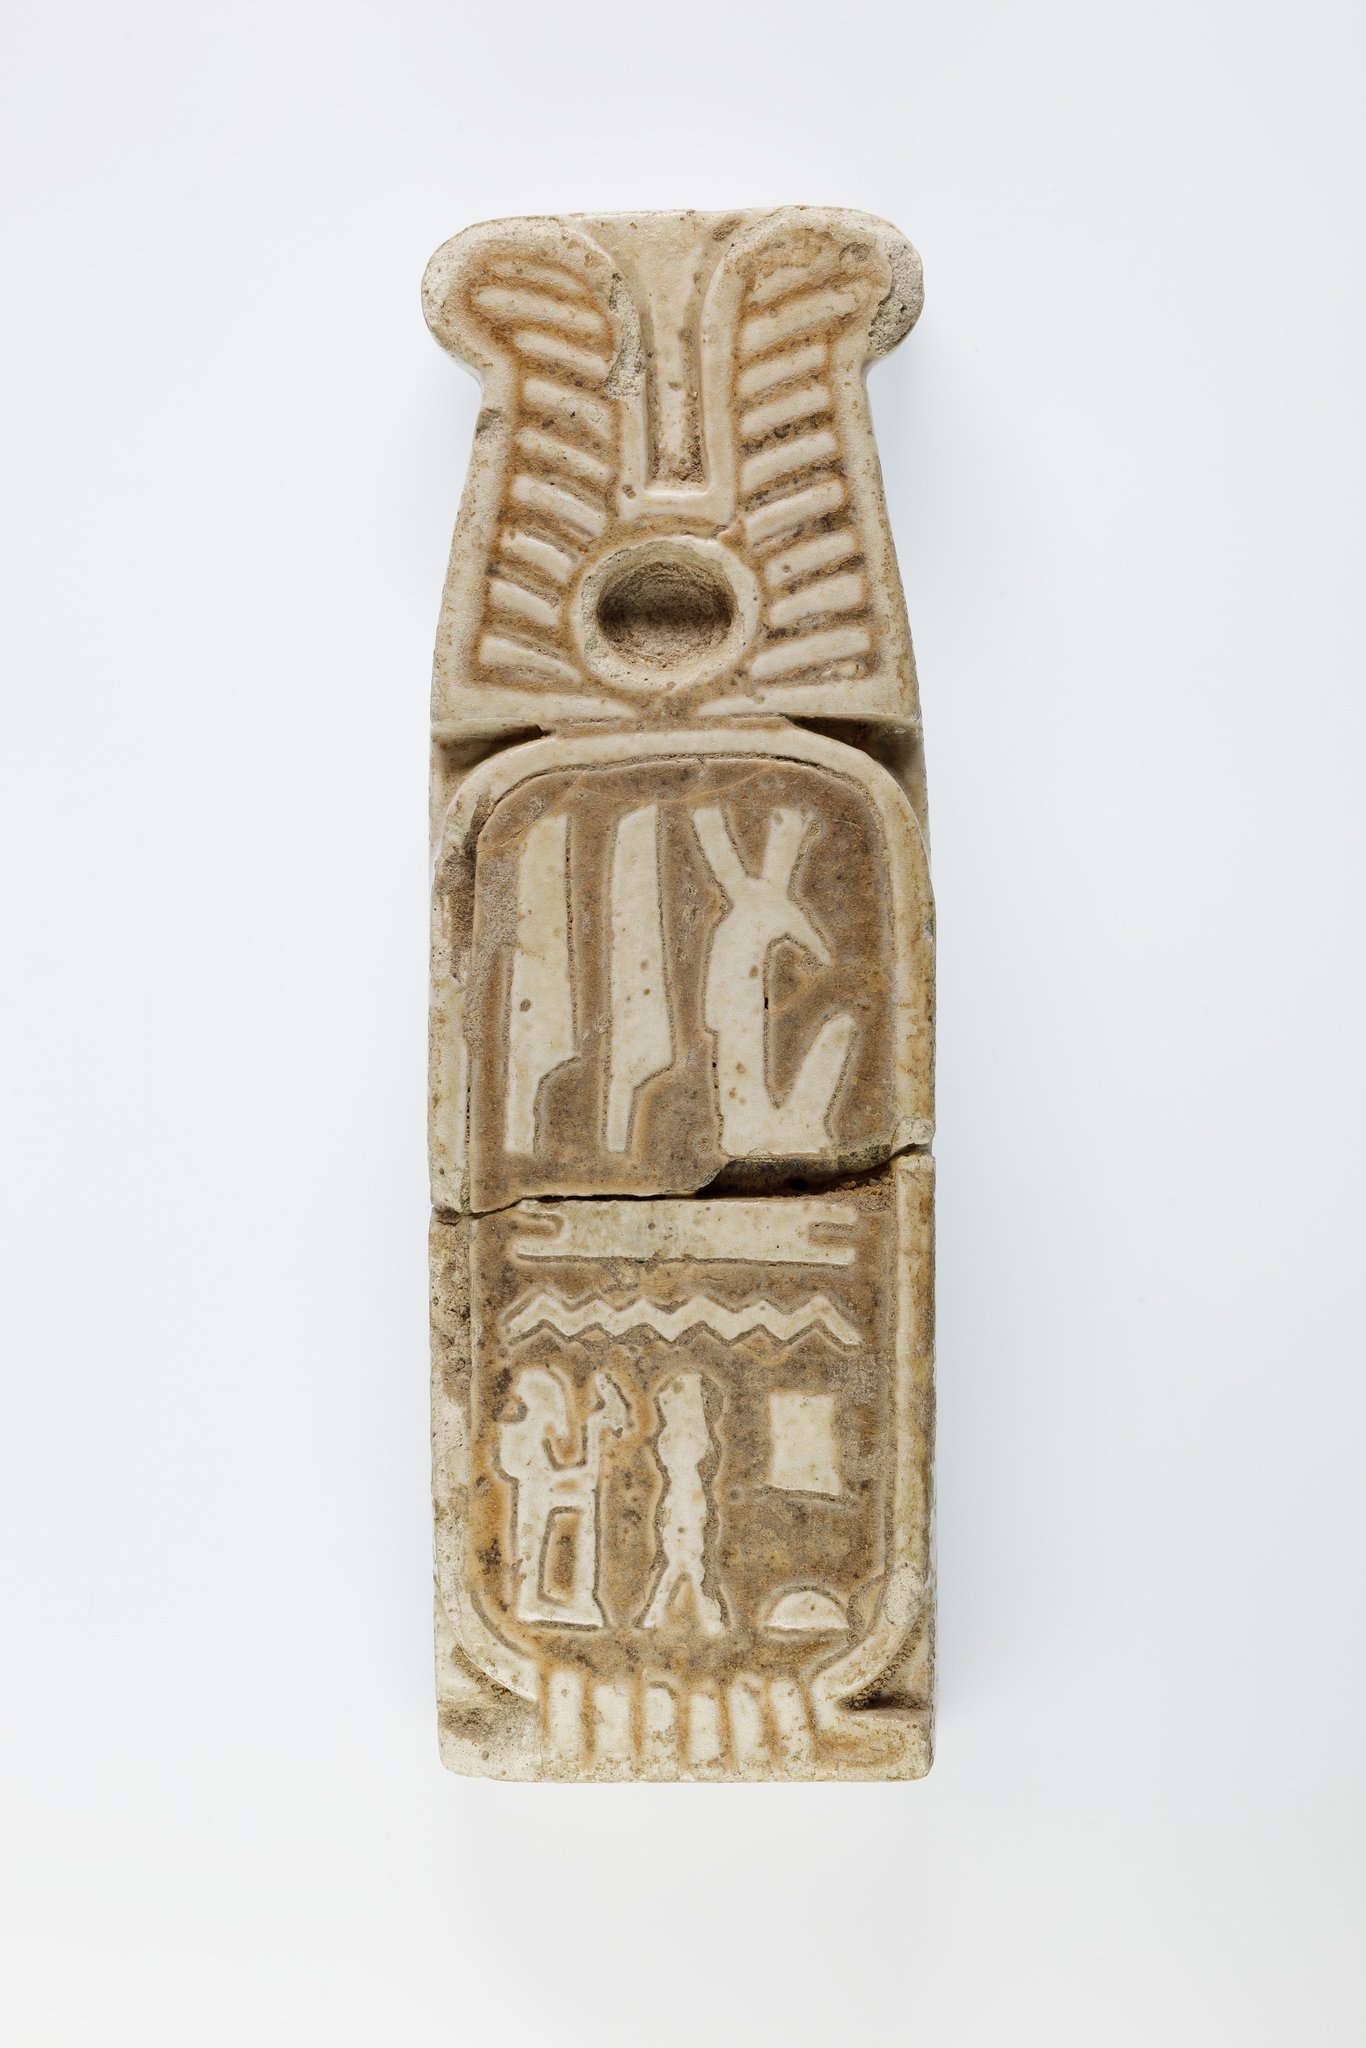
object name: plaque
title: Plaque inlaid with Cartouche of Seti II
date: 1200-1194 BCE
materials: faience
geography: egypt